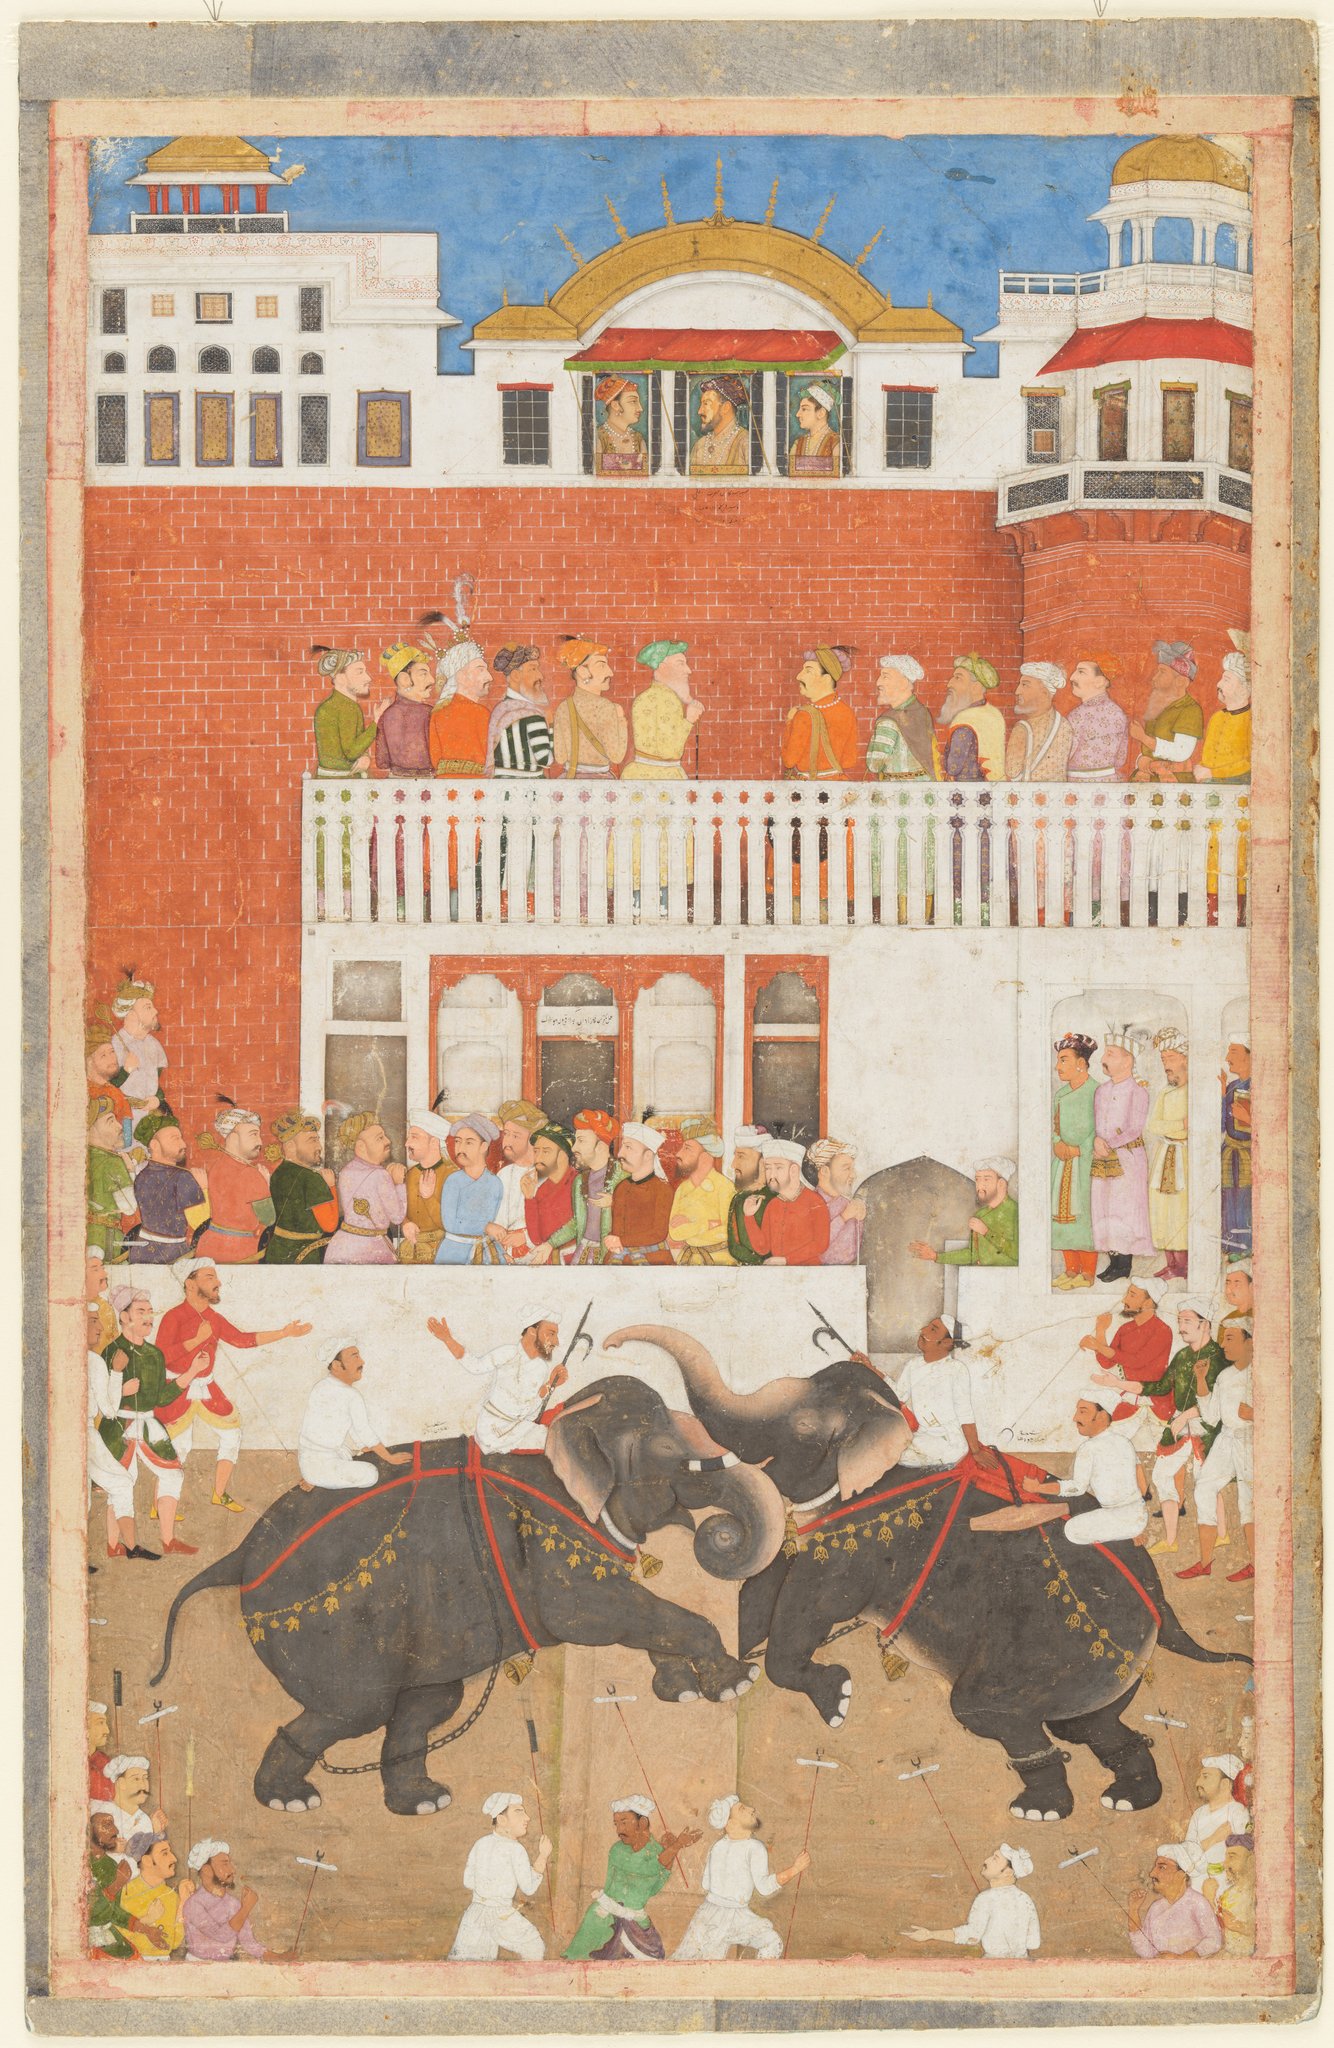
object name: folio from an illustrated manuscript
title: "Shah Jahan Watching an Elephant Fight", Folio from a Padshahnama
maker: bulaqi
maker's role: artist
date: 1639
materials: gold, ink, paper, watercolor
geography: india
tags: men,spectators,elephants